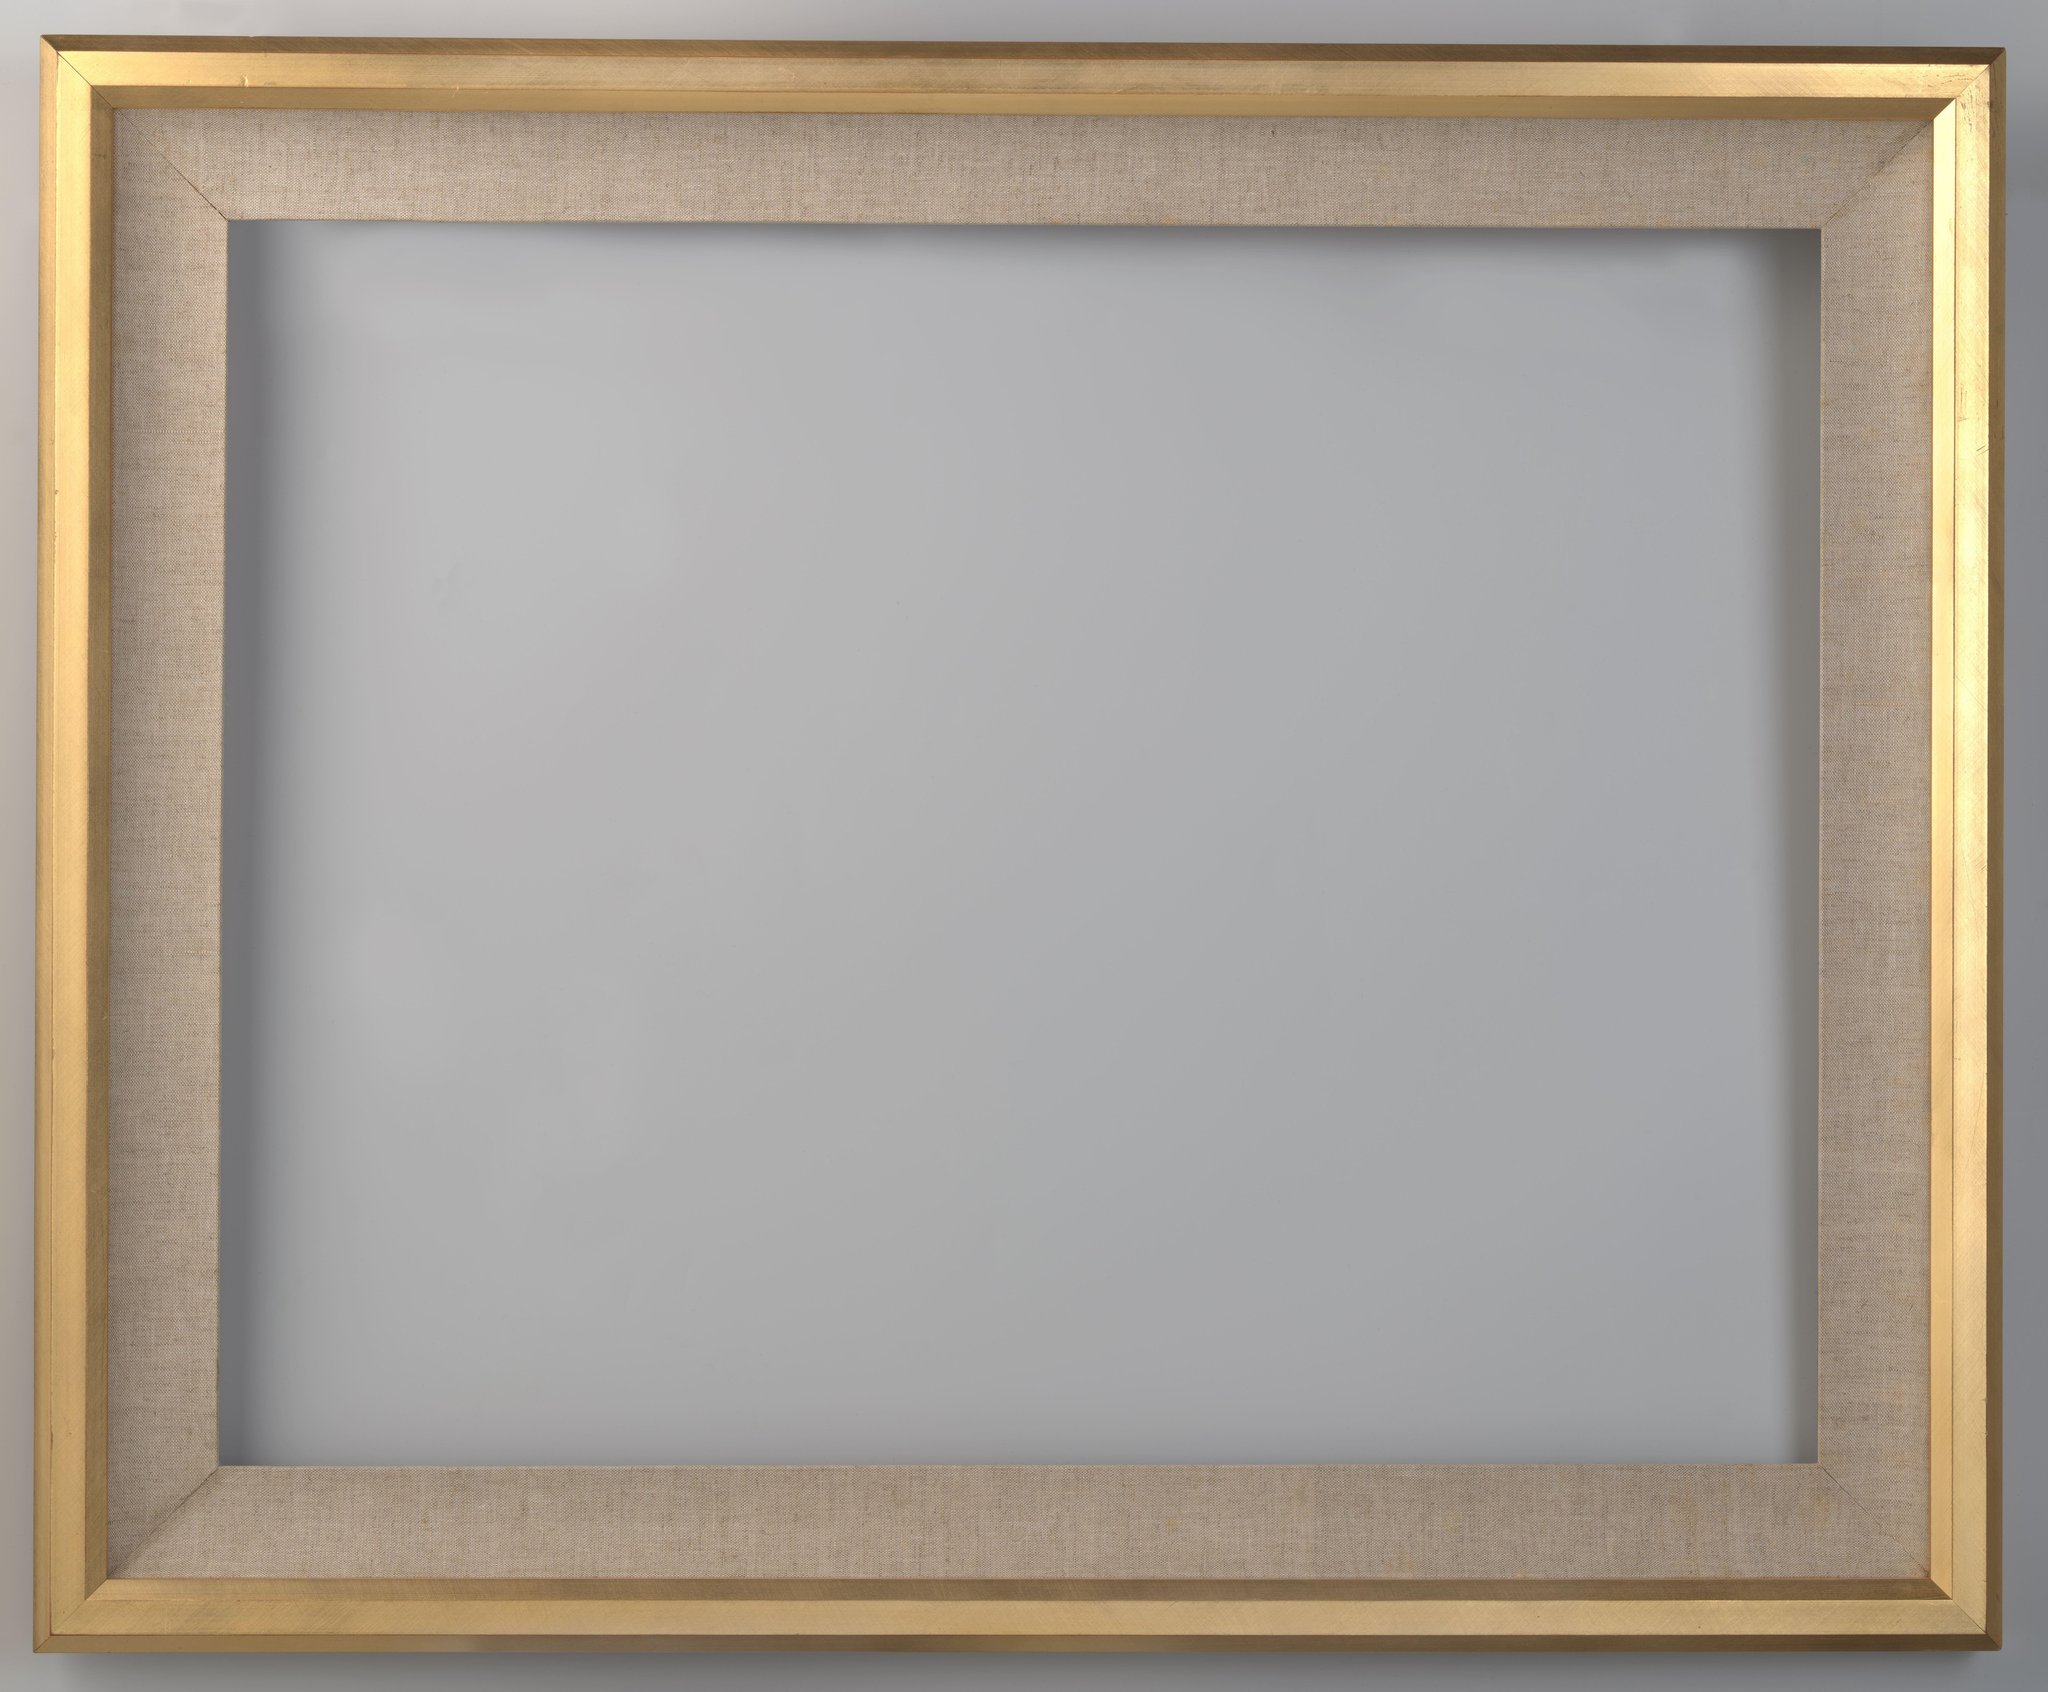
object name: frame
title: Lijst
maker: Anonymous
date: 1959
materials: wood